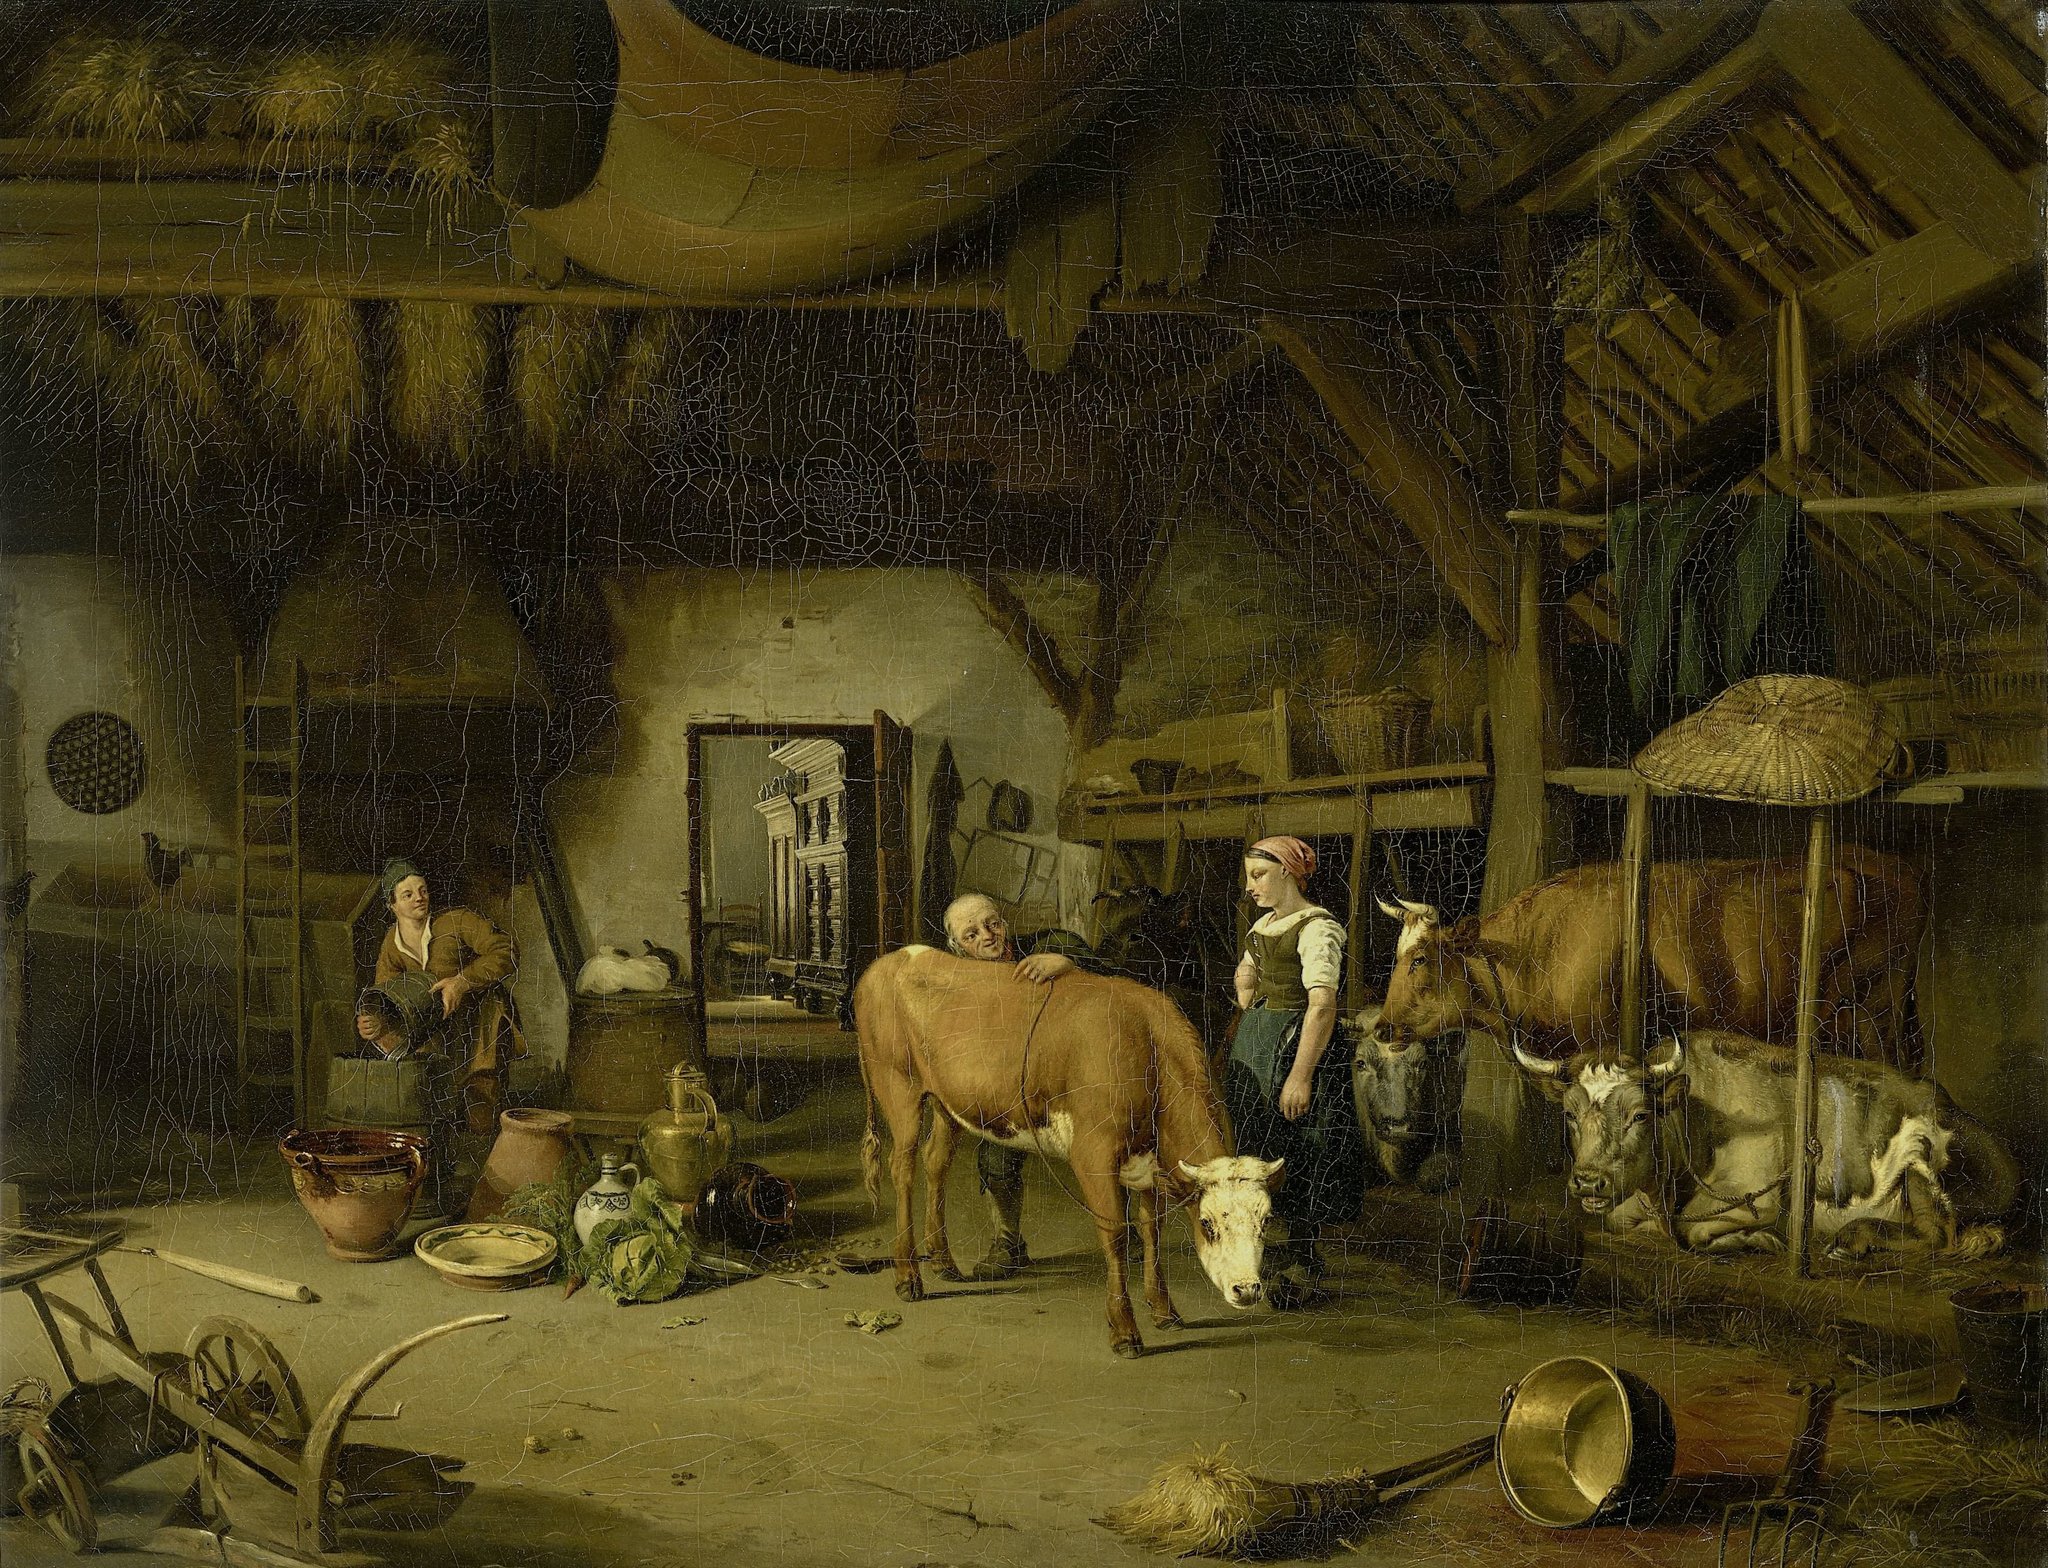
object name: painting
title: Peasant Interior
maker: james de rijk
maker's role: draughtsman, painter, print maker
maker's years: 1806-1882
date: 1830-1860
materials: canvas, oil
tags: stall, stable, farm (building) - aa - civic architecture: inside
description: Boerendeel. Boer en boerin in een stal met koeien, verspreid over de vloer liggen een ploeg, melkketel, een hooivork, bezem en kruiken.. Een openstaande deur geeft een doorkijkje naar de woonkamer van de boerderij.